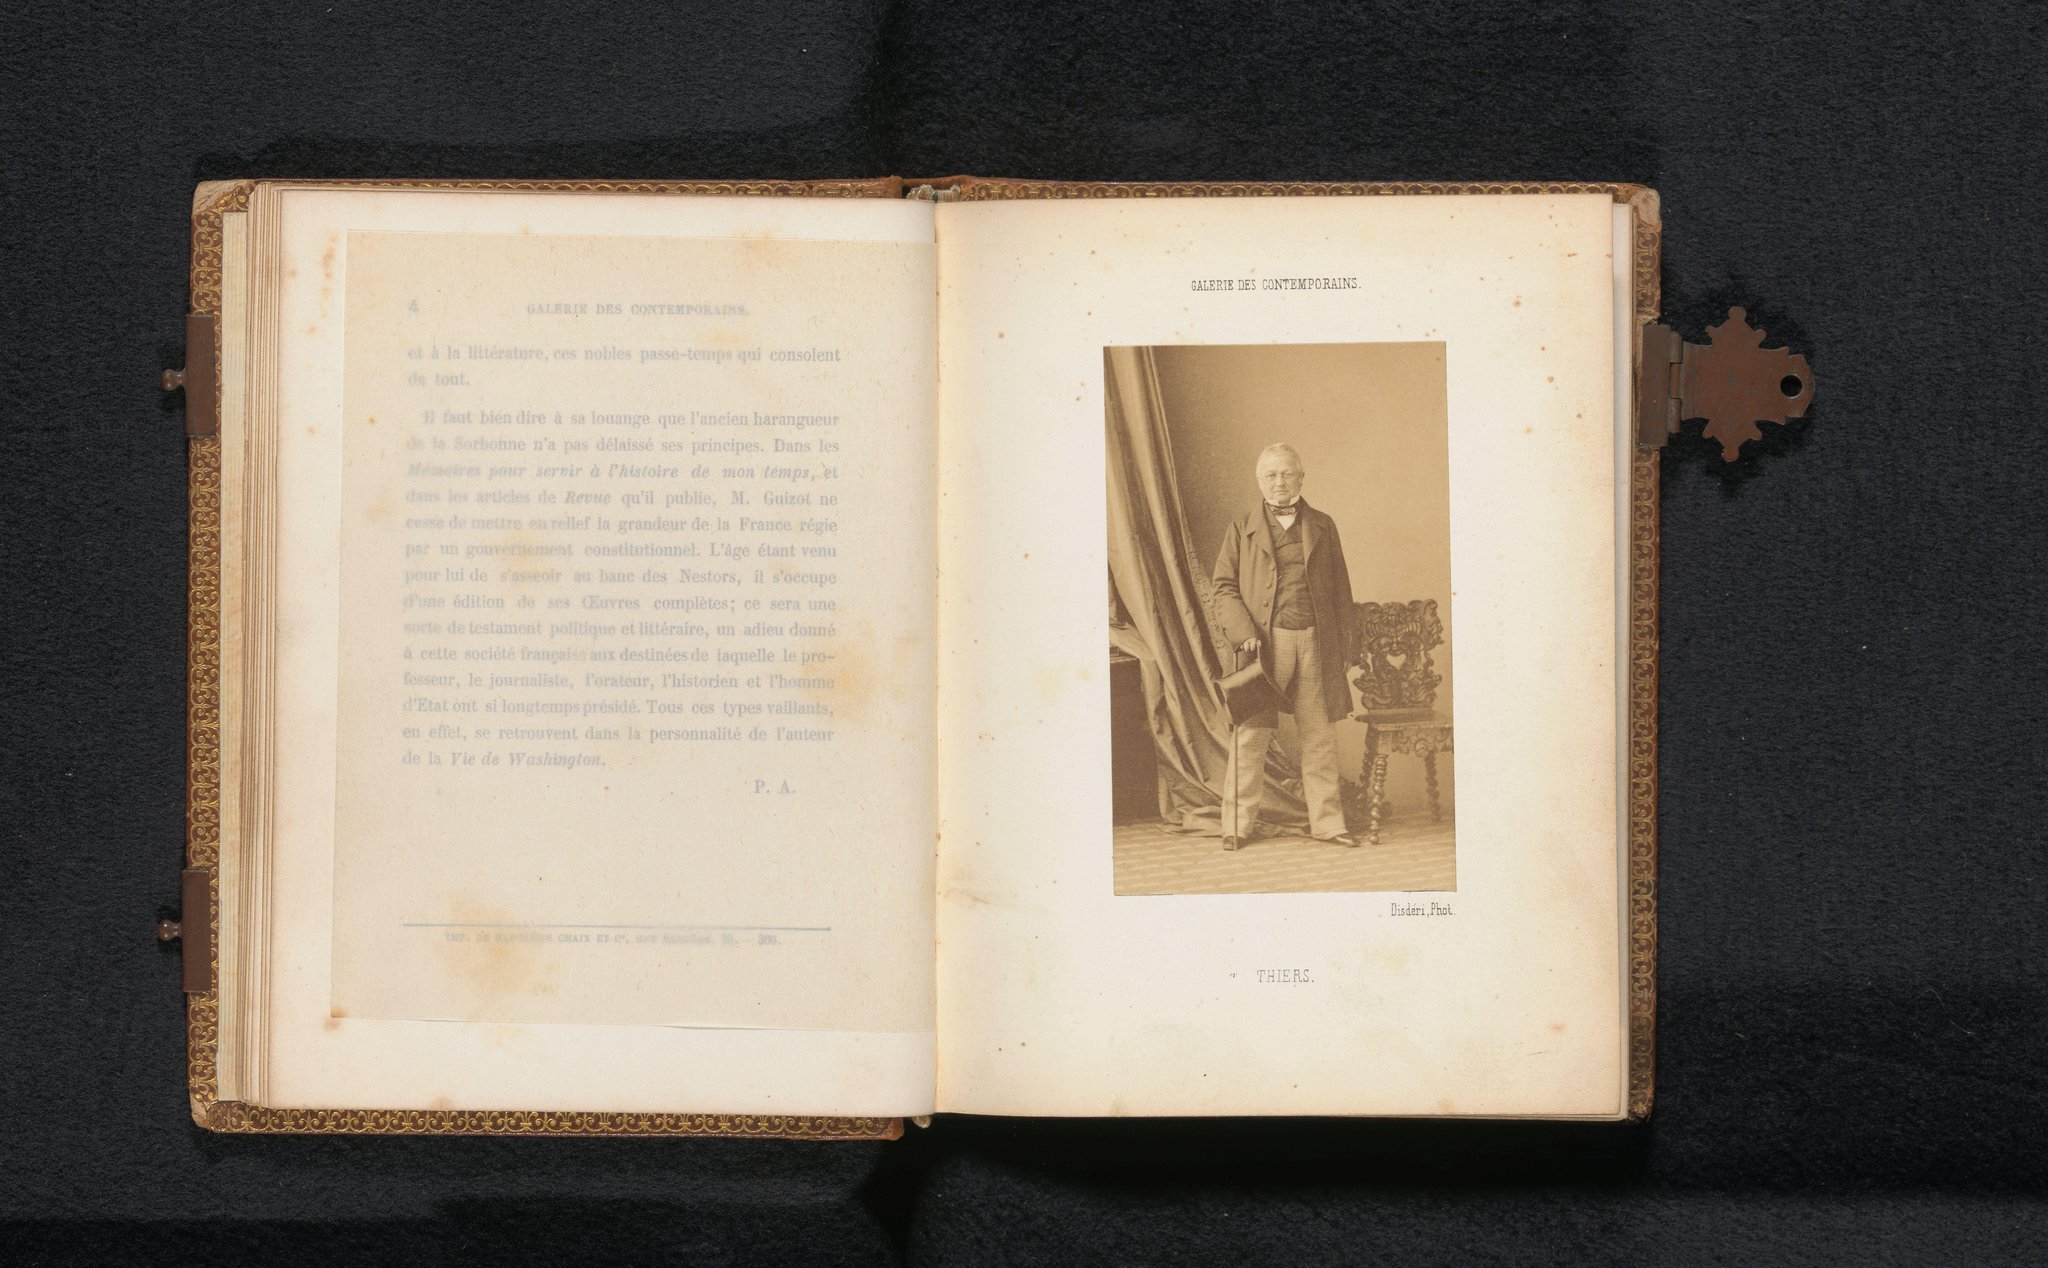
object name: photograph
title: Portret van Adolphe Thiers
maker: andré-adolphe-eugène disdéri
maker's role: fotograaf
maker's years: 1819-1889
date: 1857-1862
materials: photographic support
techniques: albumen print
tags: politician, adult man, historical persons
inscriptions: inscription: ‘Galerie des Contemporains’